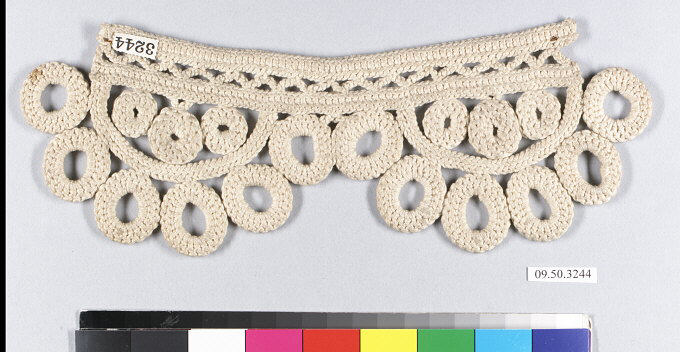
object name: sample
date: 1801-1900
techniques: crochet